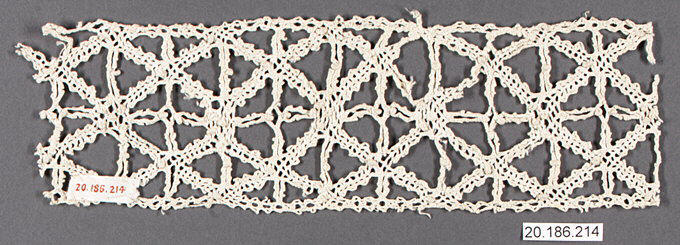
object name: insertion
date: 1501-1600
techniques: lace